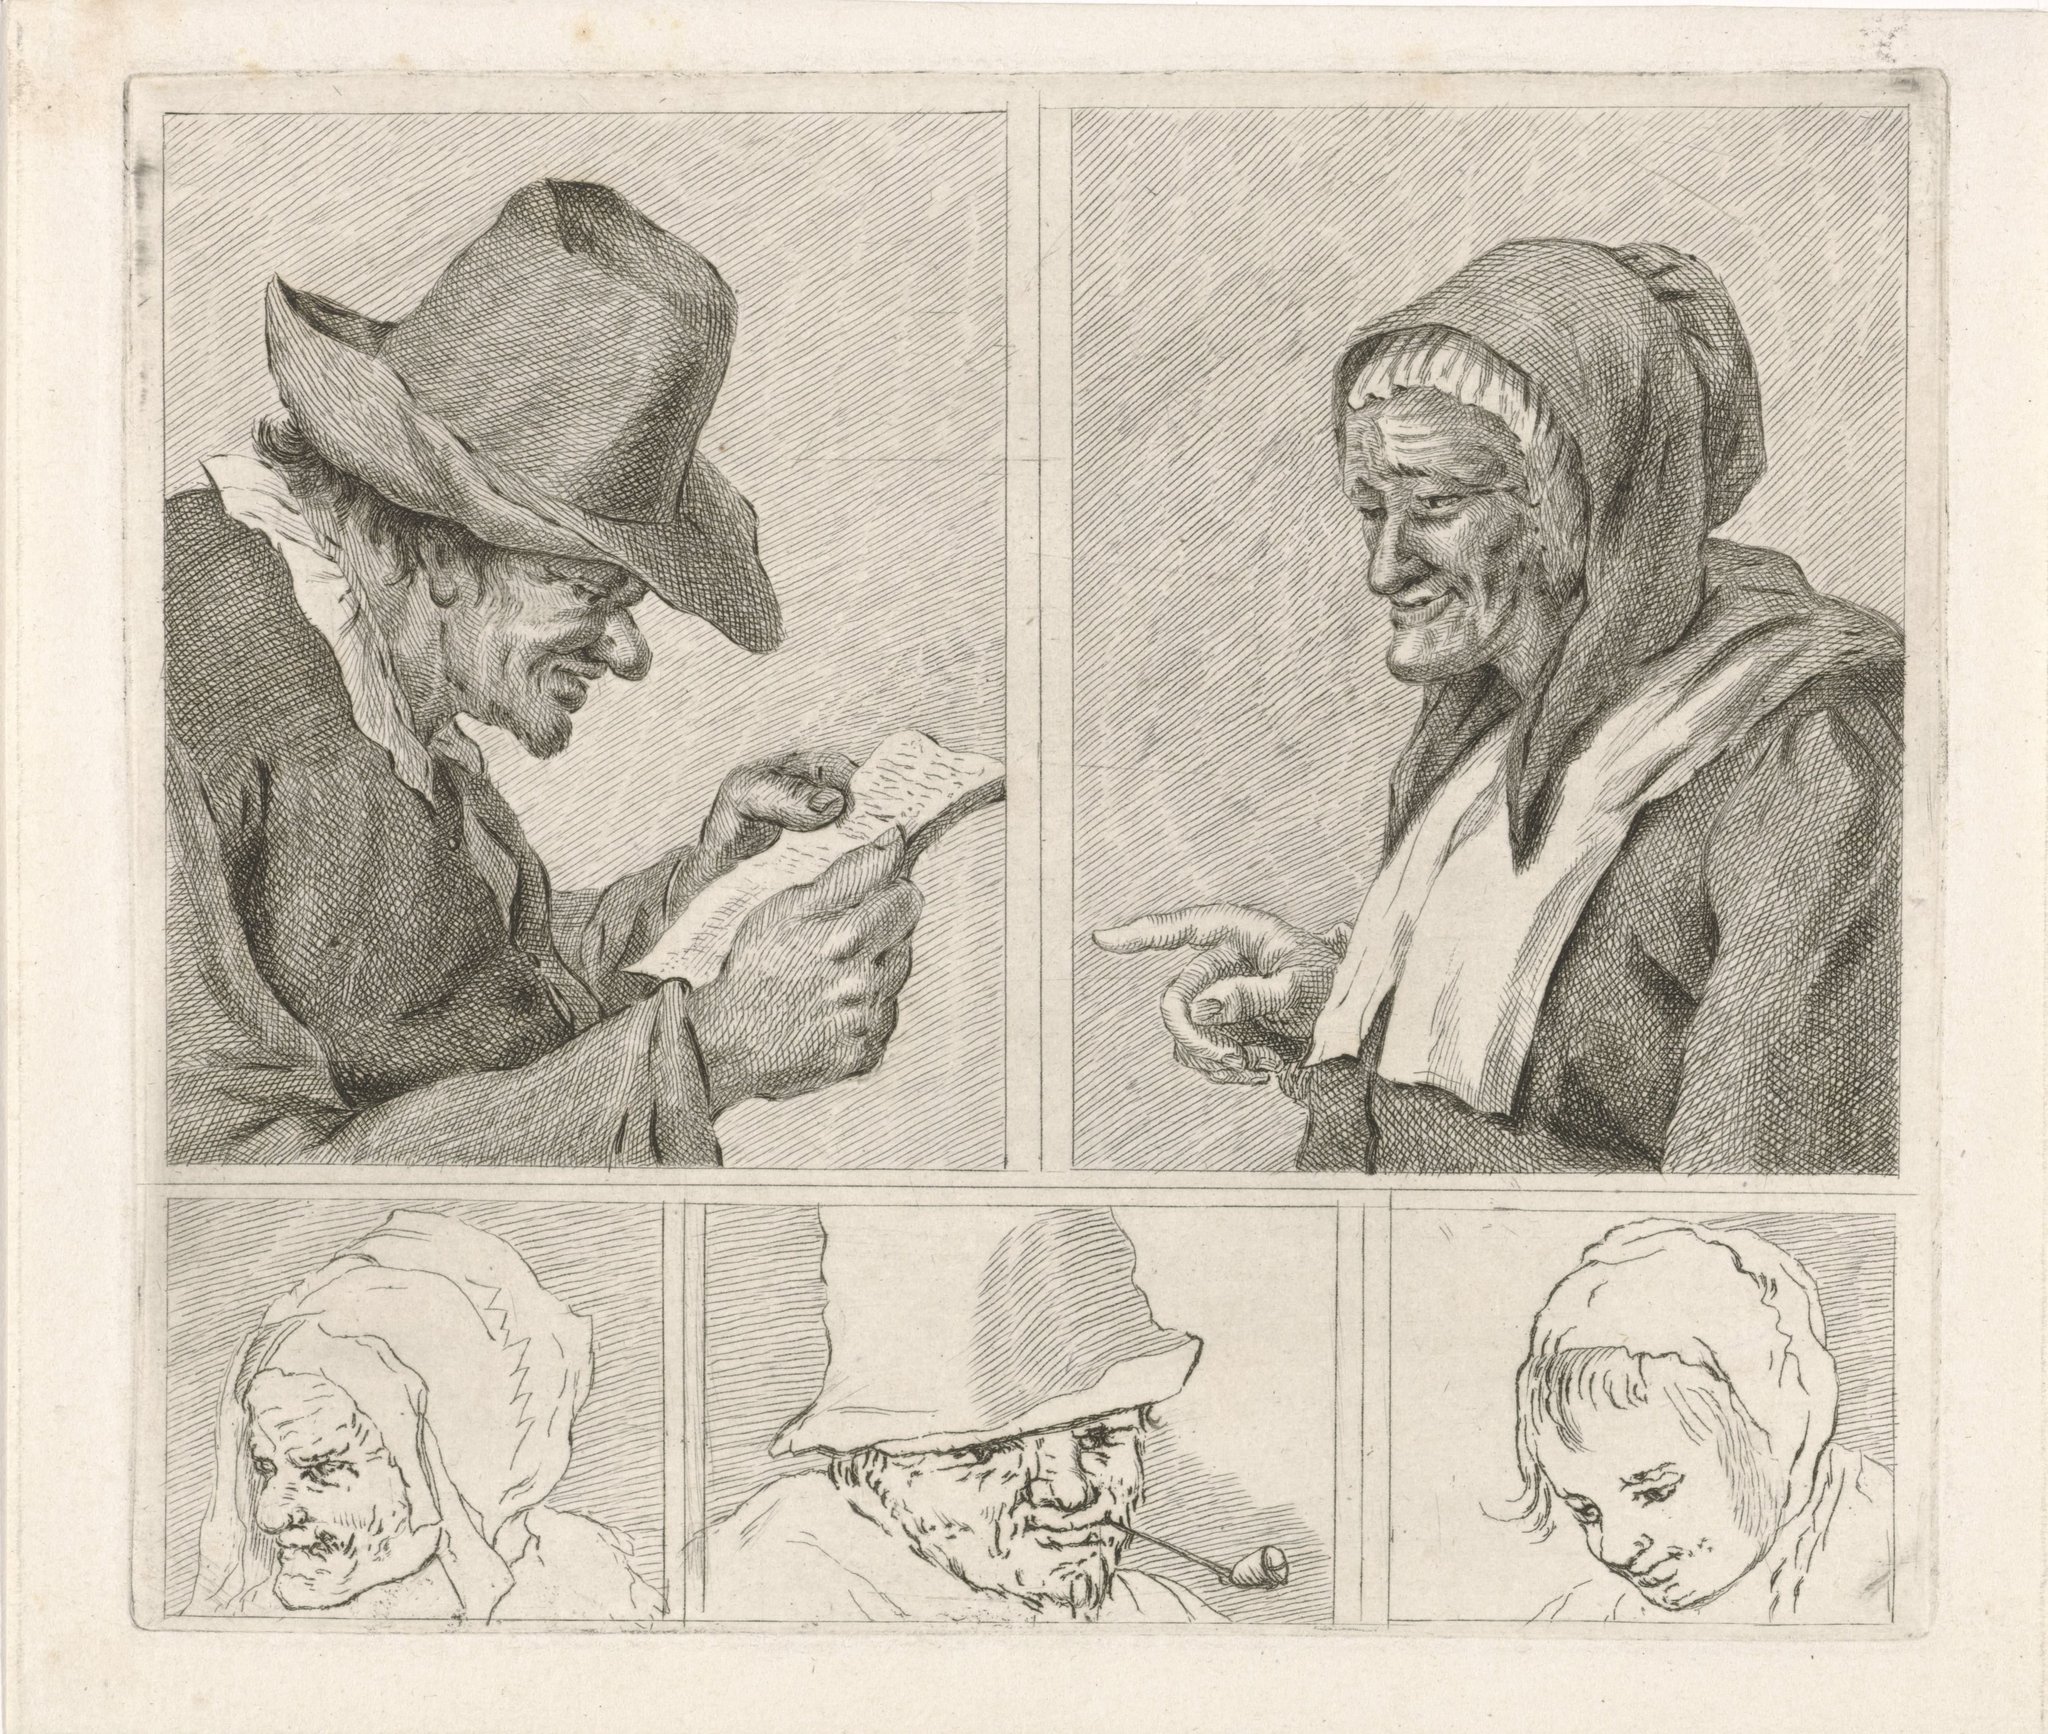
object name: print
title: Lezende man en oude vrouw en drie koppen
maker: pieter de mare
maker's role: print maker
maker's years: 1758-1796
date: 1768-1796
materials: paper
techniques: etching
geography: leiden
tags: reading, old woman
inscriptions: collector's mark: Lugt 240